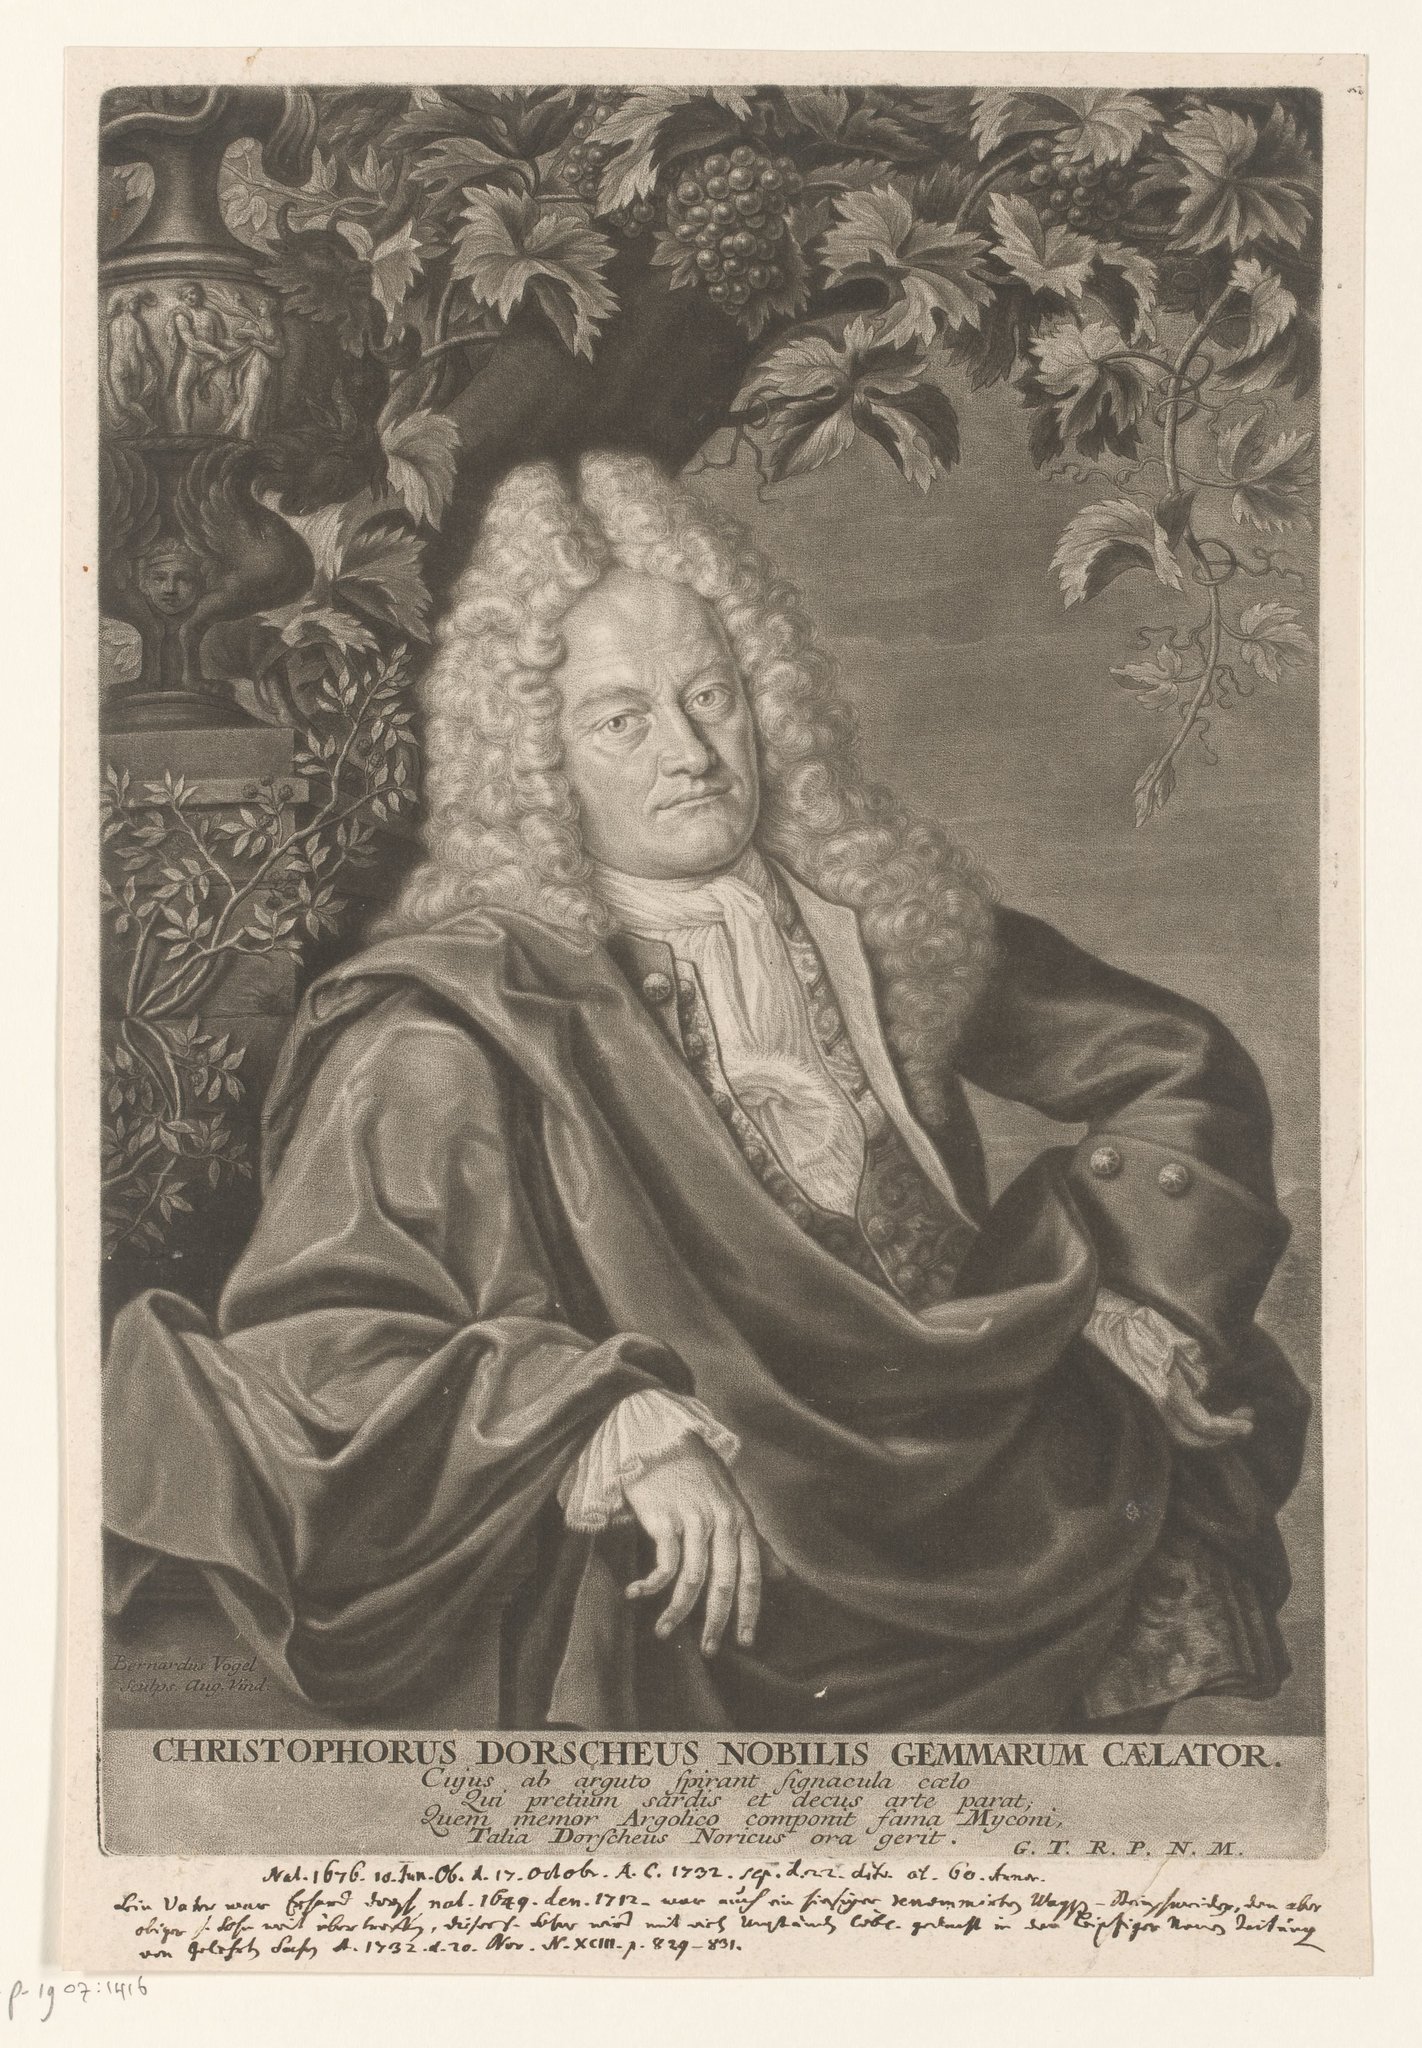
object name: print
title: Portret van Christoph Dorsch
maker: bernhard vogel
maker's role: draughtsman, painter, print maker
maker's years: 1683-1737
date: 1693-1737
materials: paper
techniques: mezzotint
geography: augsburg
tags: die cutter, vine, historical persons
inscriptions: collector's mark: Lugt 2228